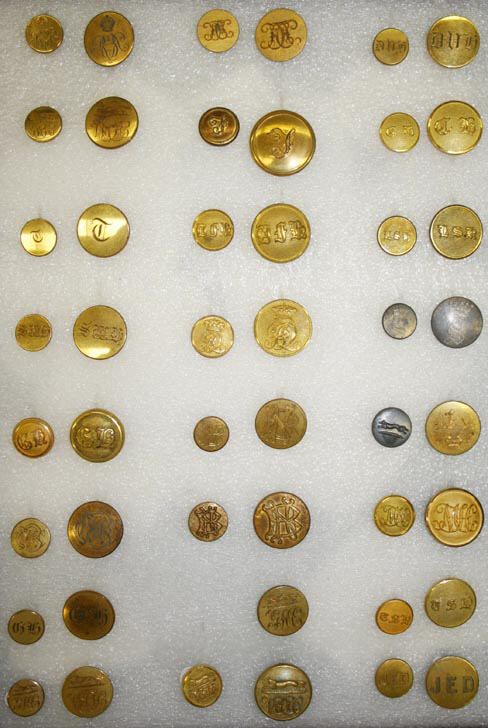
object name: button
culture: british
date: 1850-1880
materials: metal